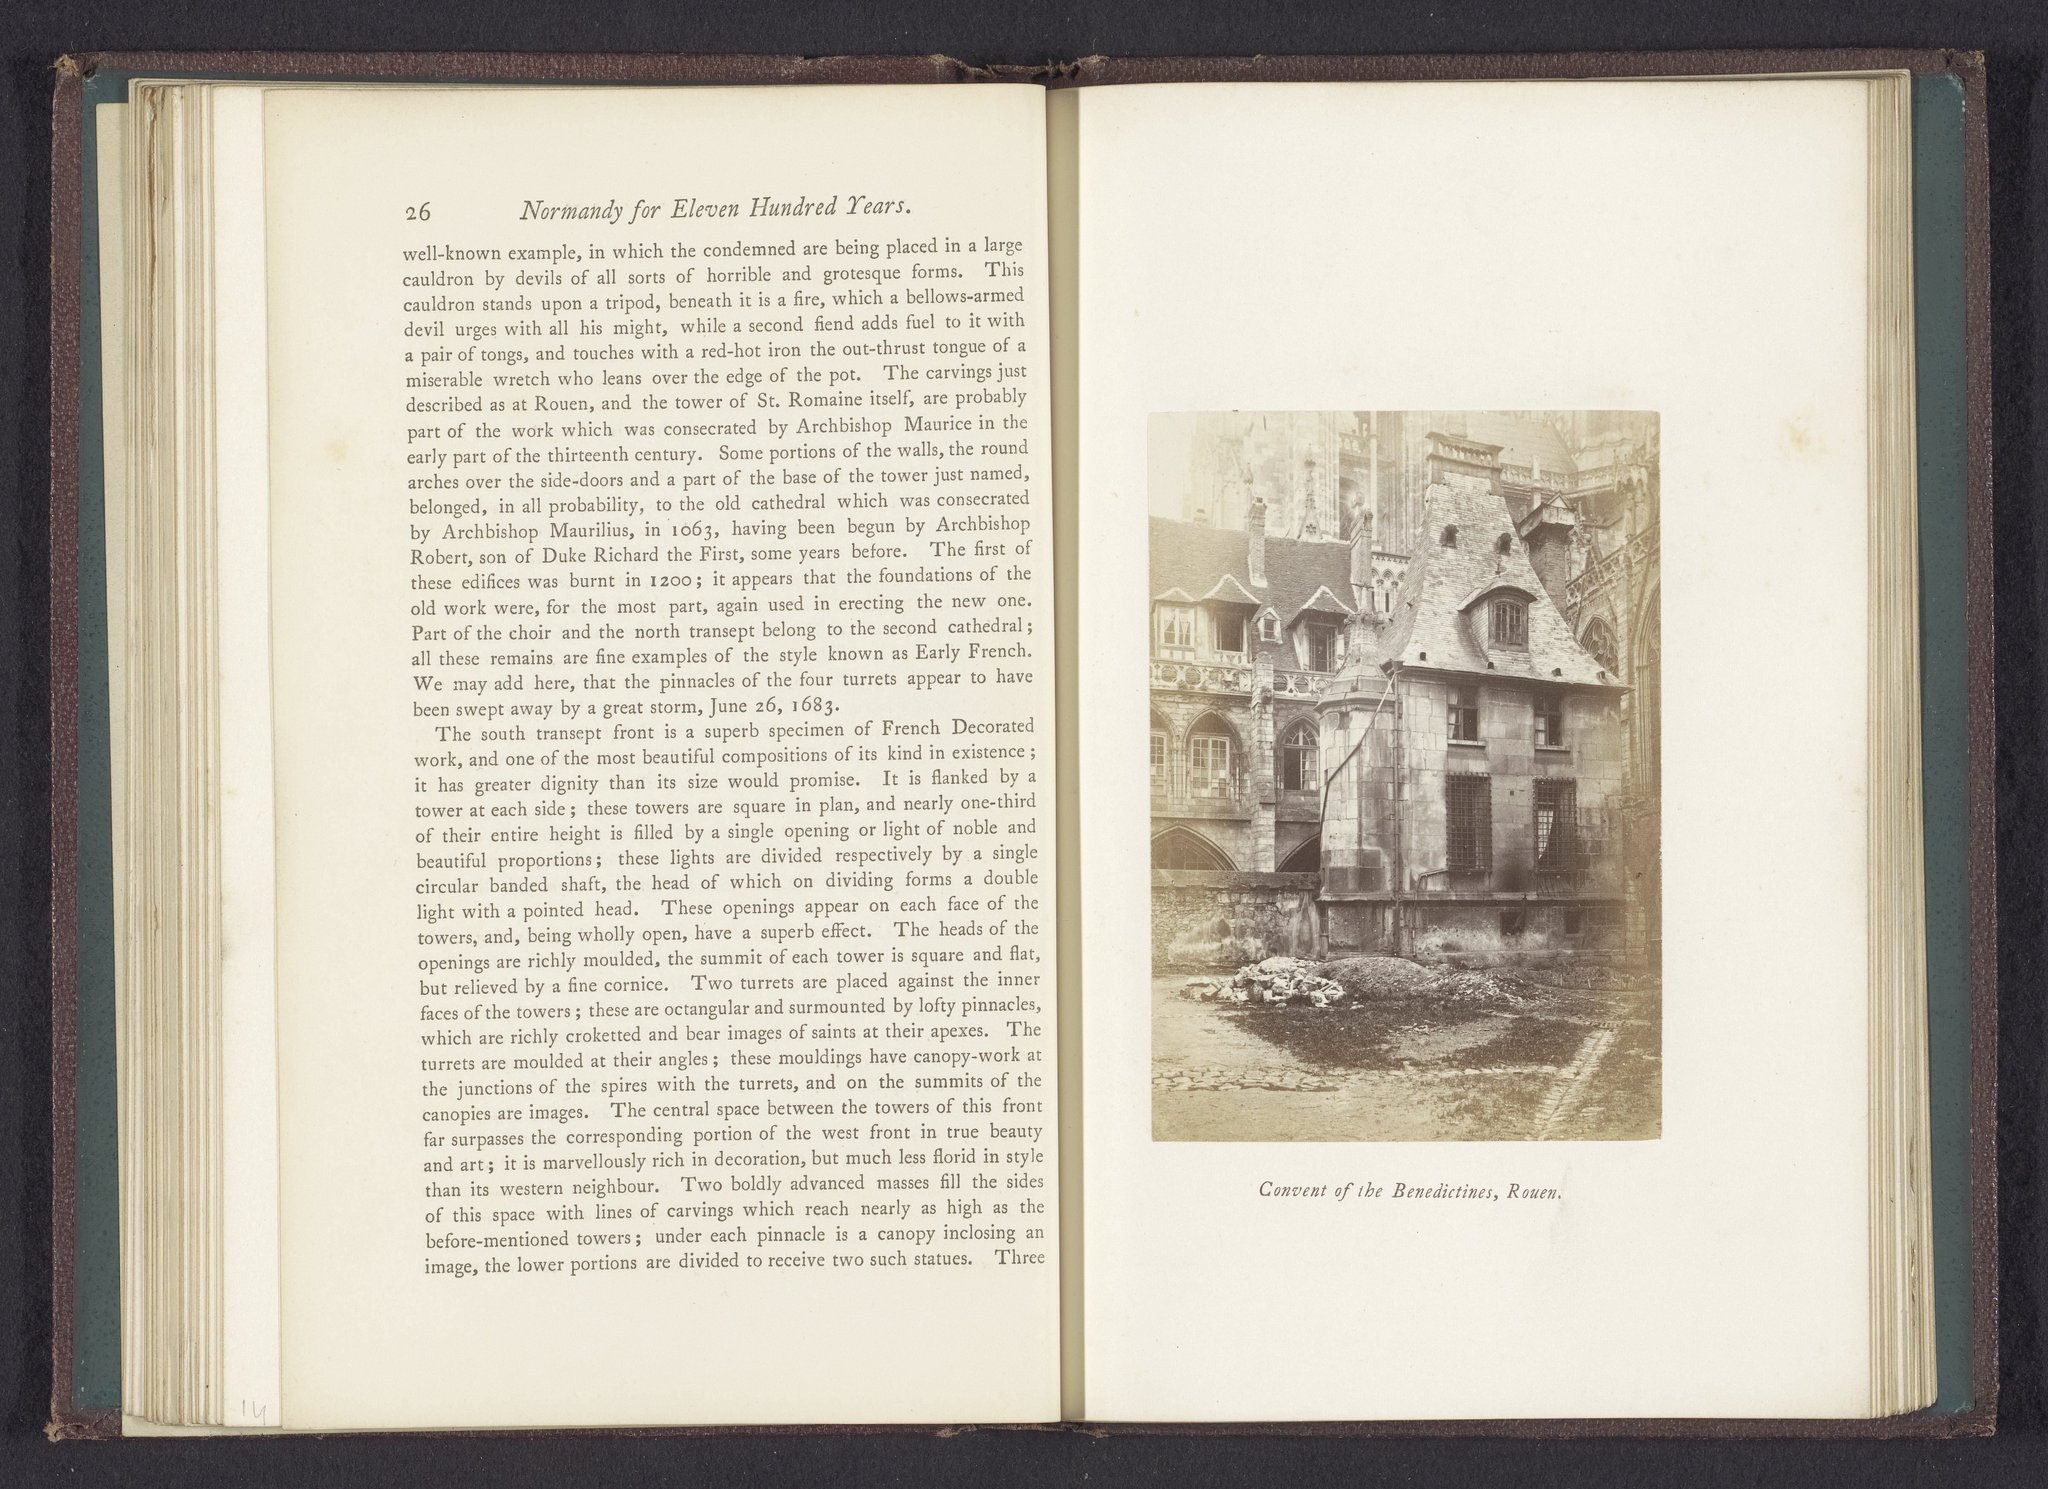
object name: page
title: Convent of the Benedictines, Rouen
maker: joseph cundall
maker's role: fotograaf, schrijver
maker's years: 1818-1895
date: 1855-1865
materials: photographic support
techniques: albumen print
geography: rouen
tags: abbey, monastery, convent ~ roman catholic church, façade (of house or building)